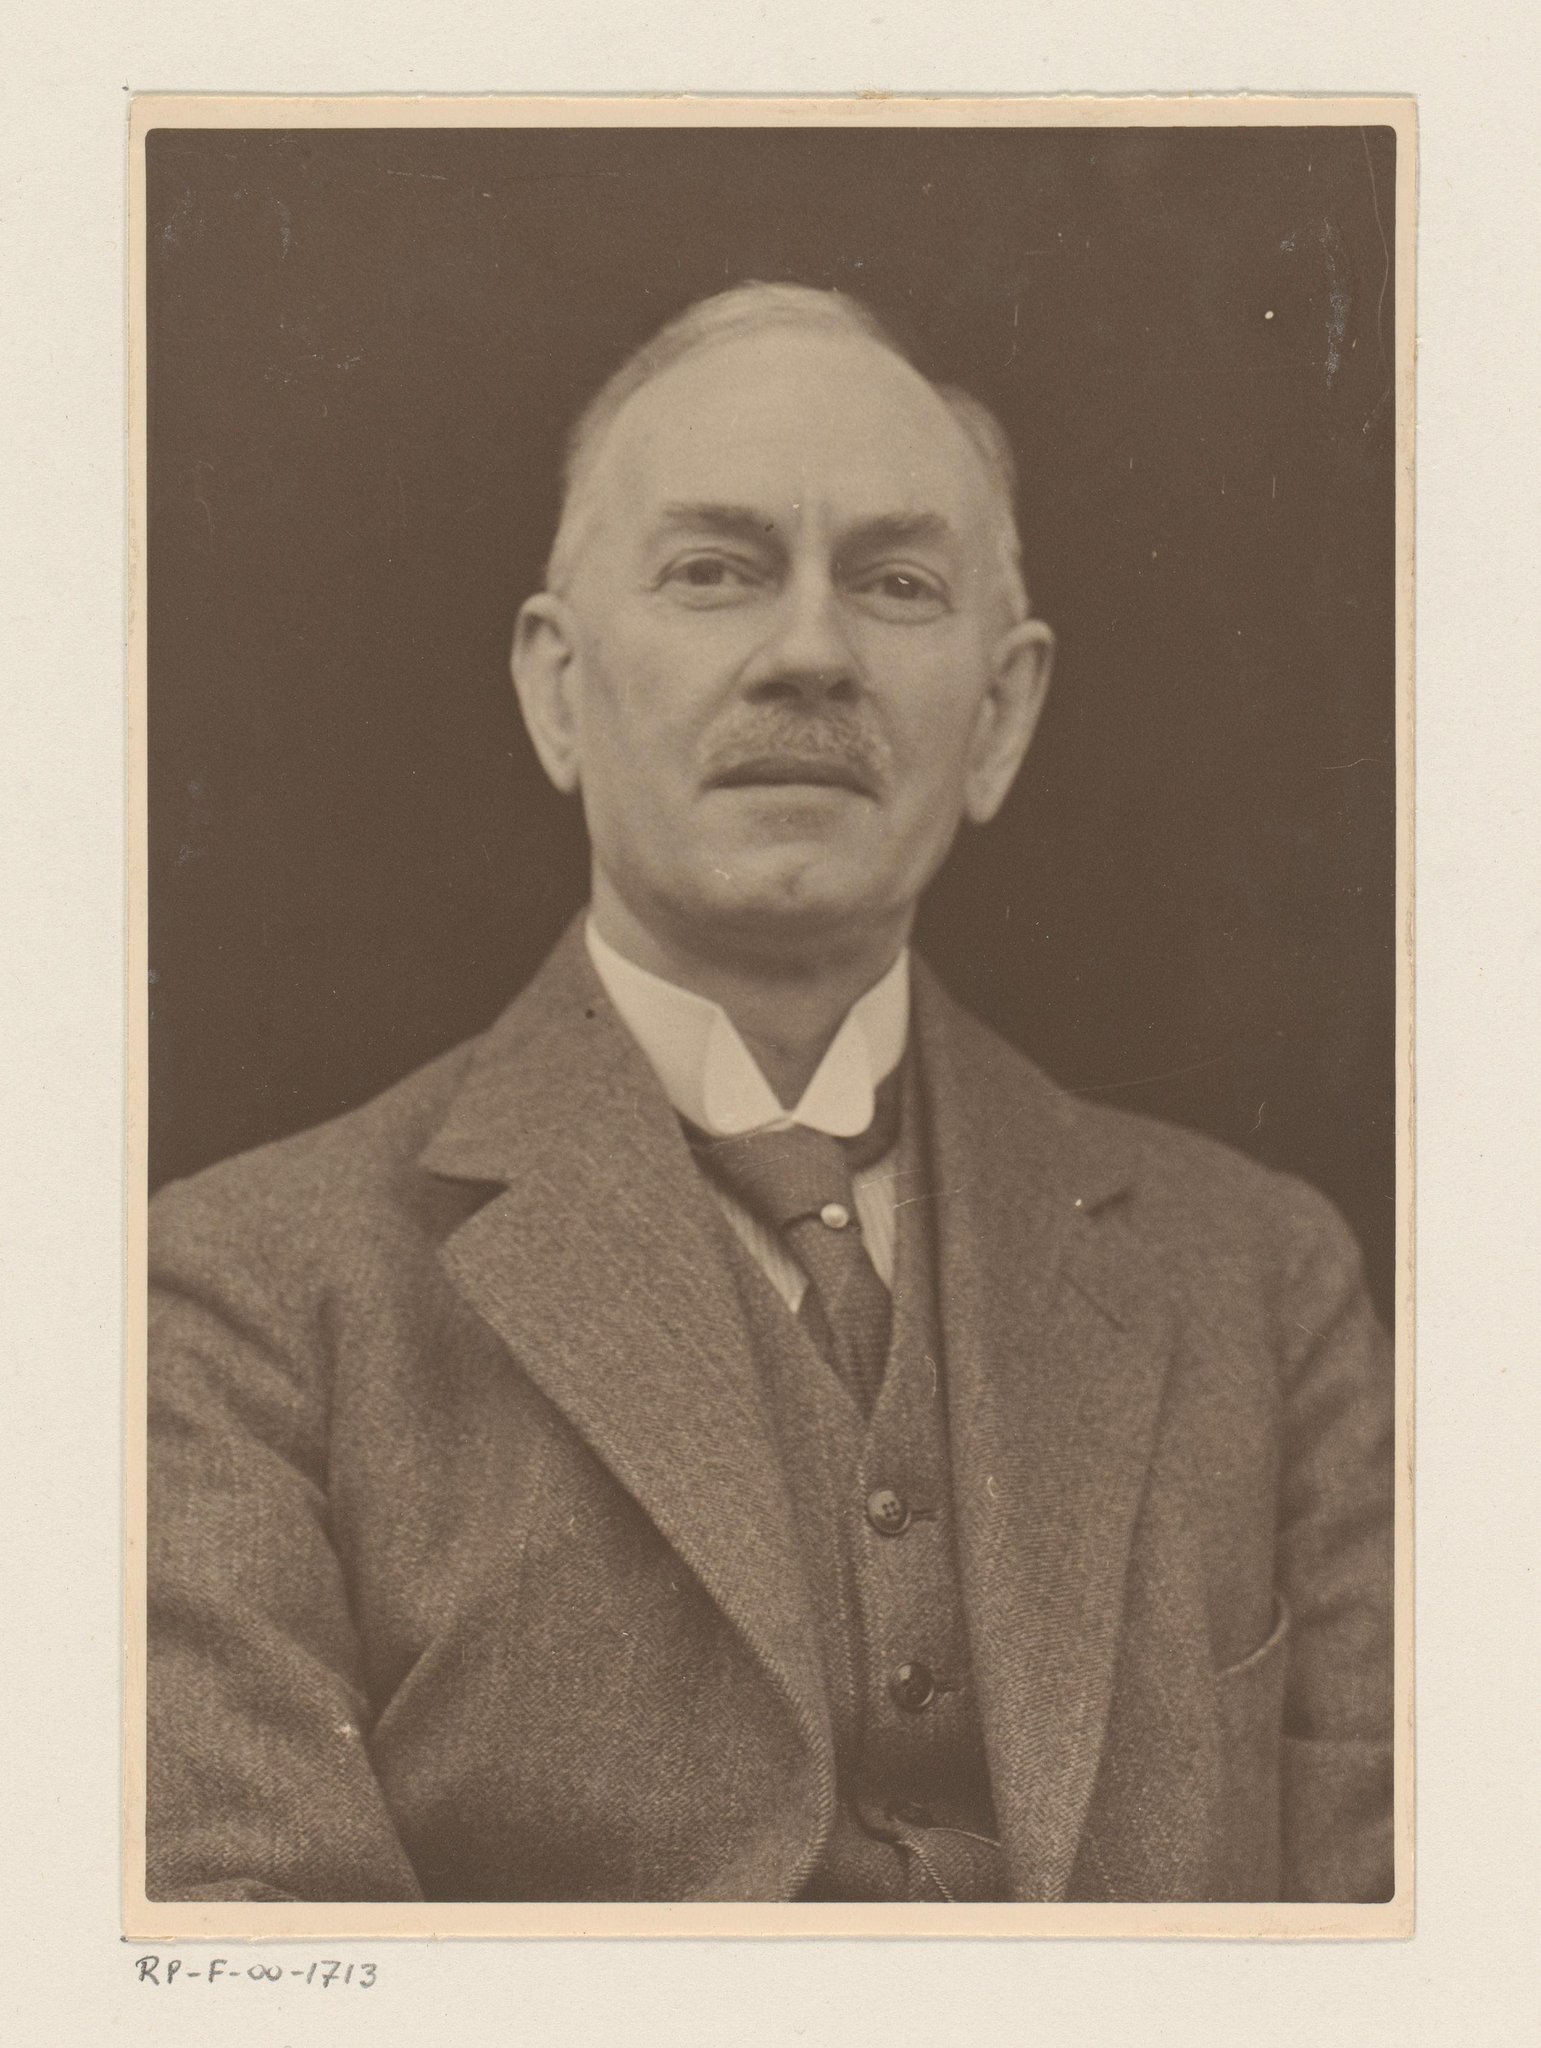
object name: photograph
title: Portret van Willem Adrianus Grondhout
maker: Anonymous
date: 1920-1934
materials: paper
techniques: gelatin silver print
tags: the hague, painter, print maker, draughtsman, willem adrianus grondhout, historical persons, portrait, self-portrait of graphic artist